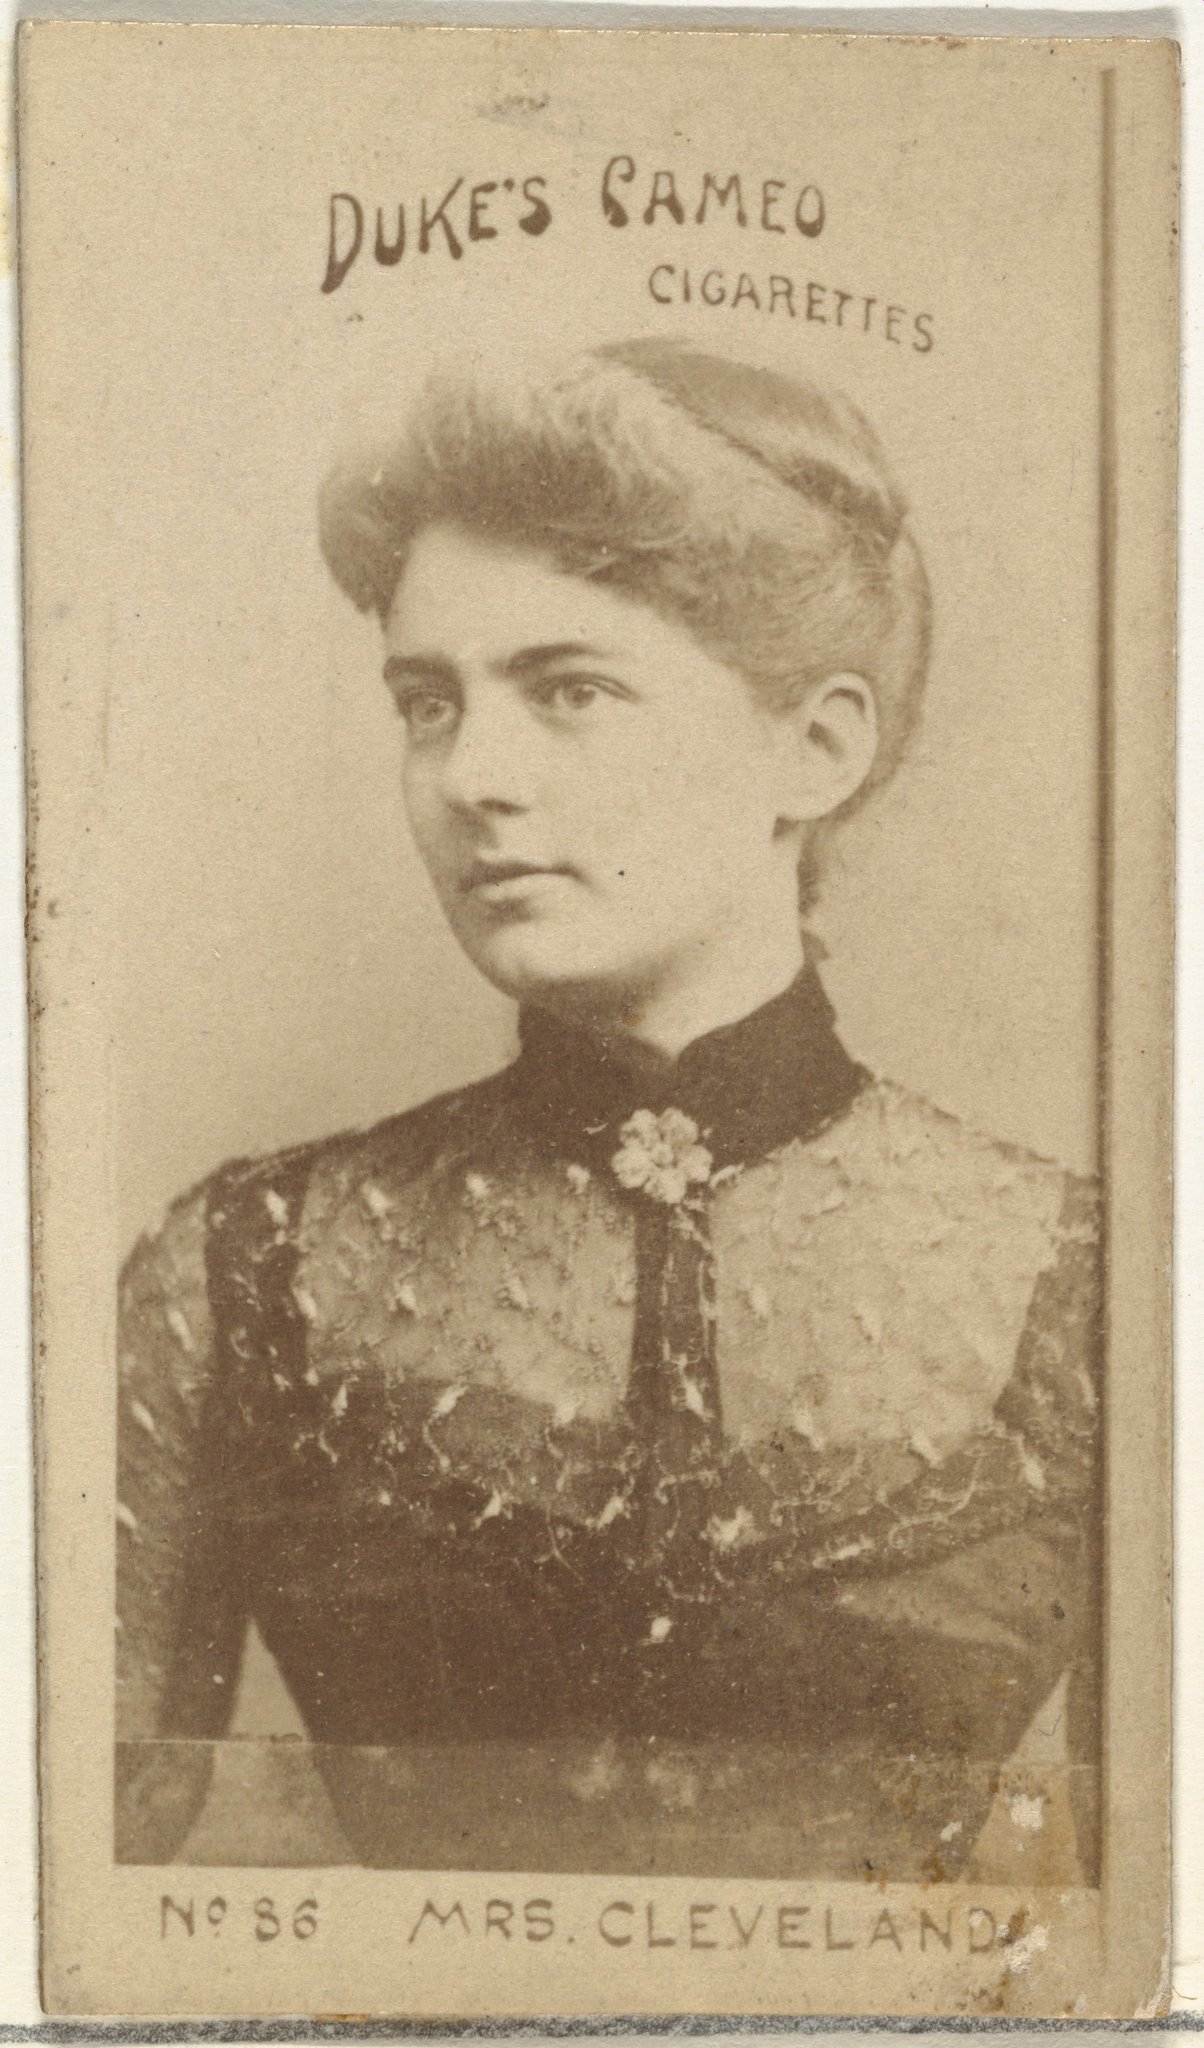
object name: photograph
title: Card Number 86, Mrs. Cleveland, from the Actors and Actresses series (N145-4) issued by Duke Sons & Co. to promote Cameo Cigarettes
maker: w. duke, sons & co.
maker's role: publisher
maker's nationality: american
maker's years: 1870-1920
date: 1880-1889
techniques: albumen silver print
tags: portraits,women,actresses